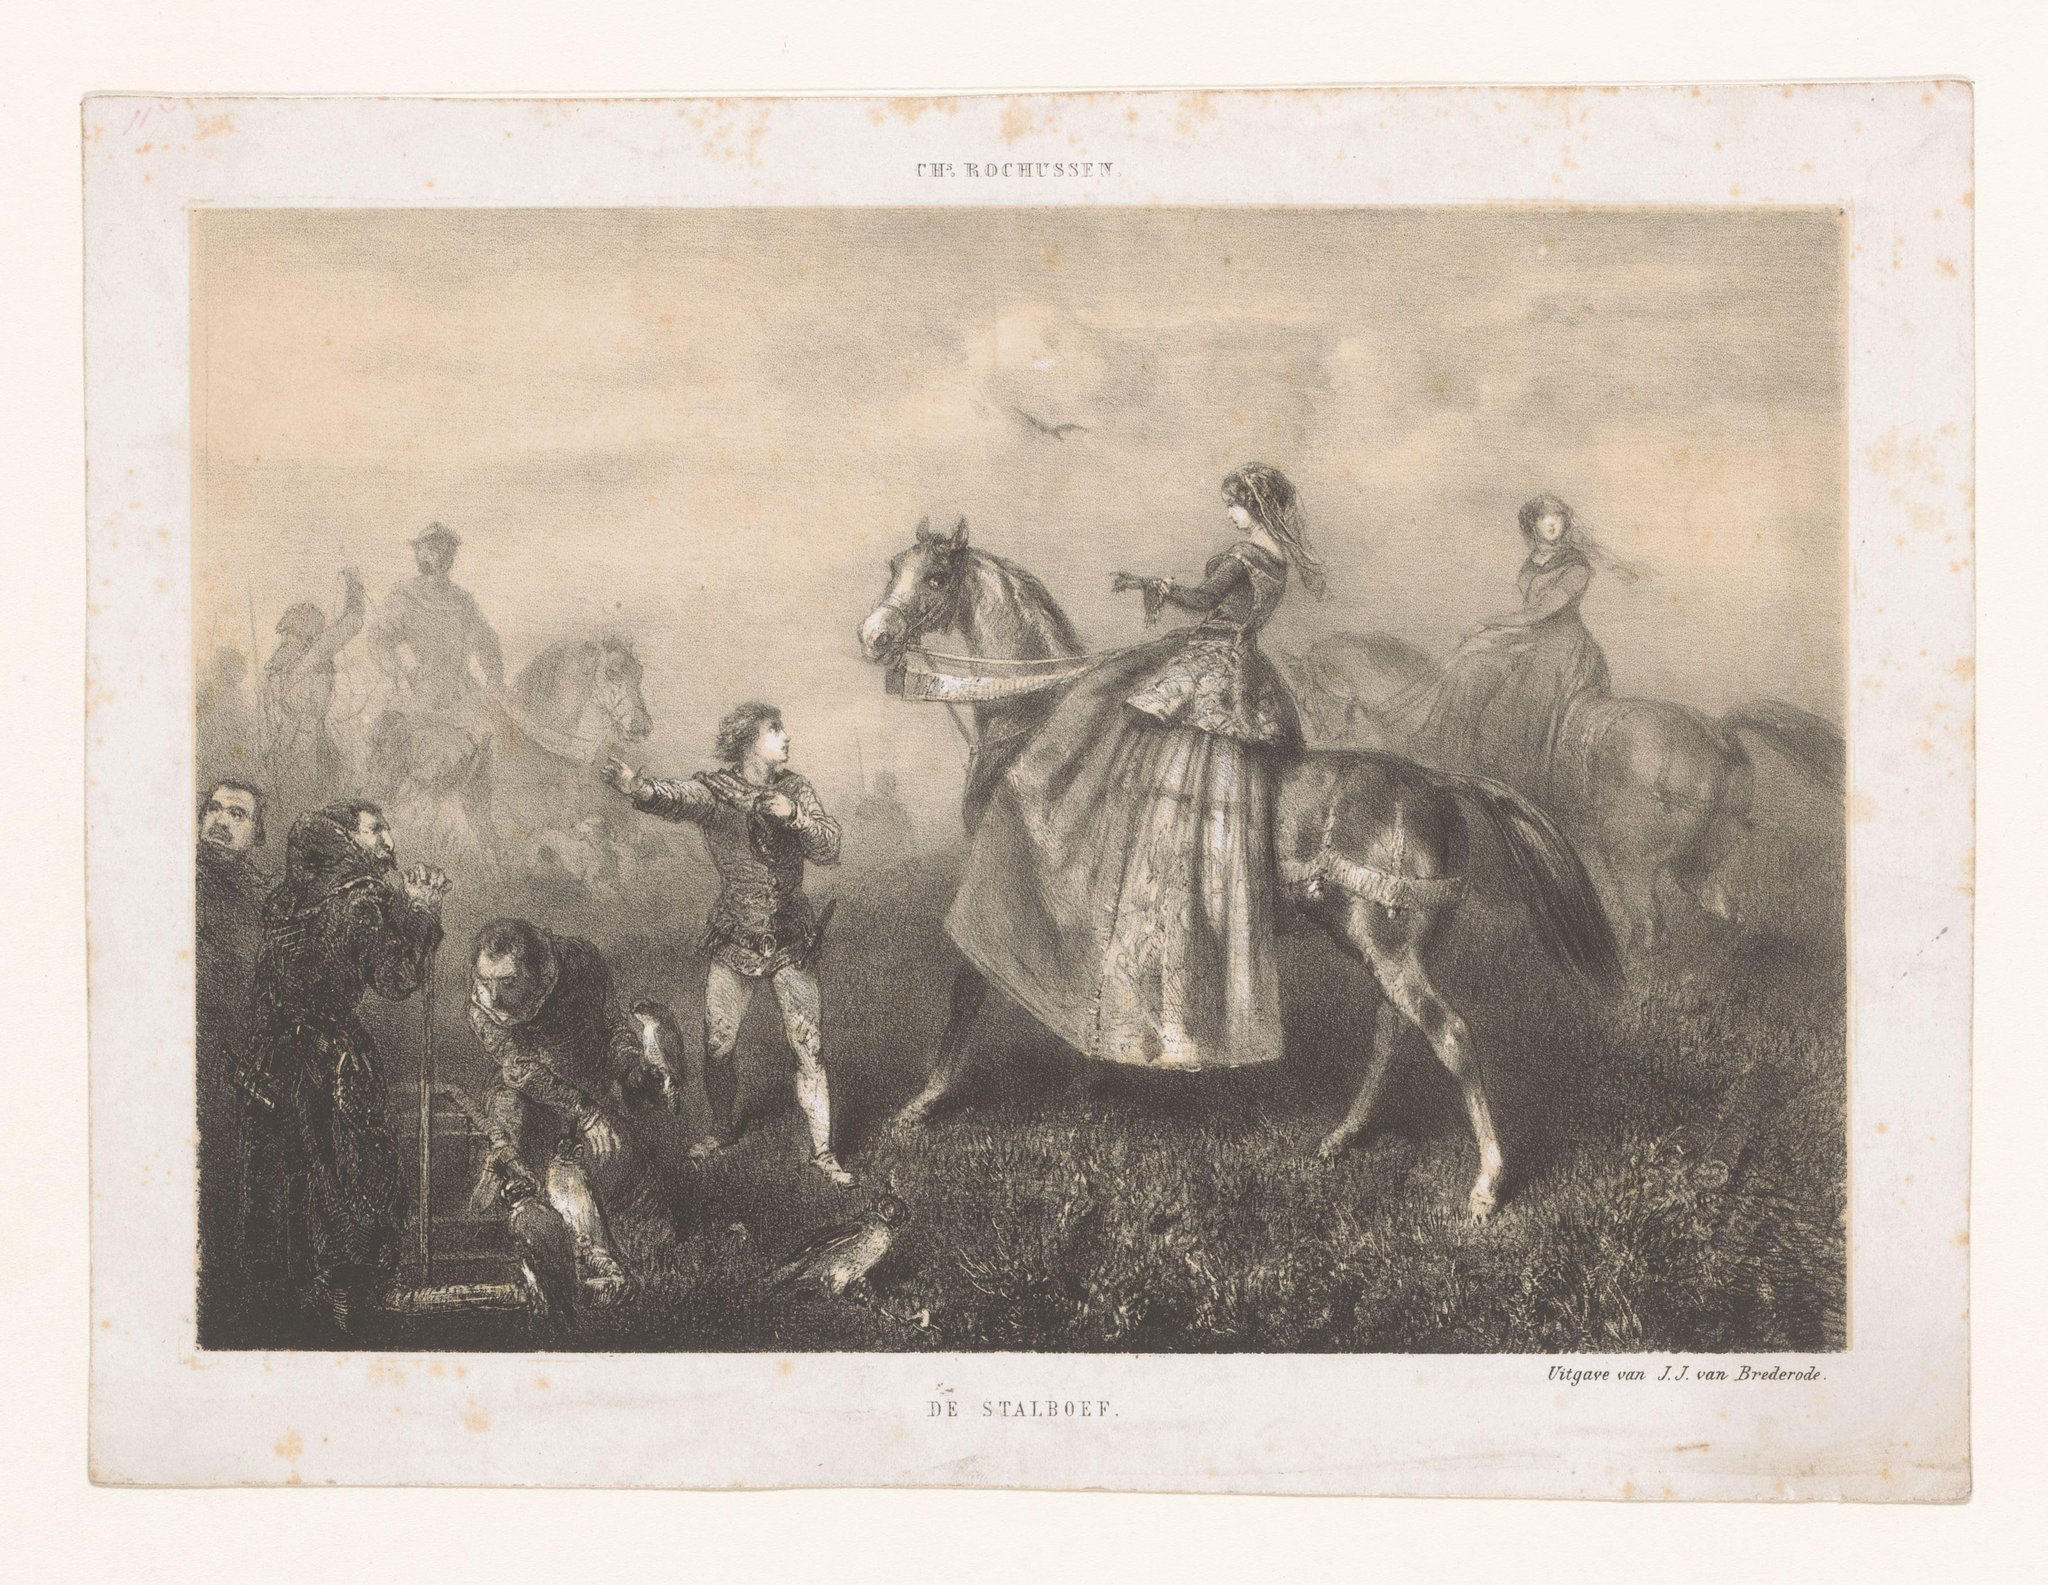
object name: print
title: De stalboef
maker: j.j. van brederode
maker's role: publisher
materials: paper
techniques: tone lithography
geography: haarlem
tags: riding a horse, ass, or mule; rider, horseman, fowling, fowler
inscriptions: collector's mark: Lugt 2228, collector's mark: Lugt 2760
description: Een vrouw te paard, vergezeld door een man en vrouw te paard in de achtergrond, staat voor drie valkeniers en een jongeman die haar op iets wijst.